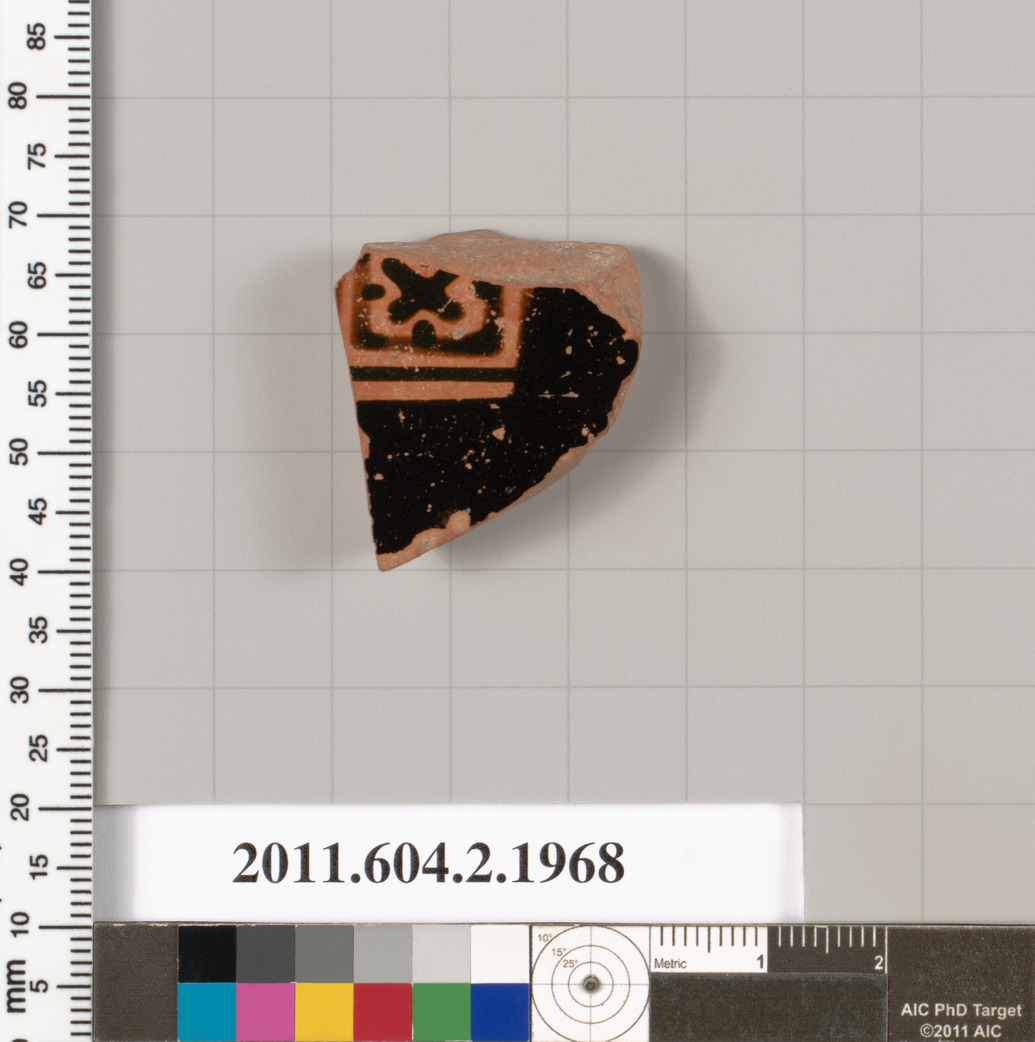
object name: krater fragment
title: Terracotta fragment of a krater (bowl for mixing wine and water)?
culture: greek, attic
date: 475-451 BCE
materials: terracotta